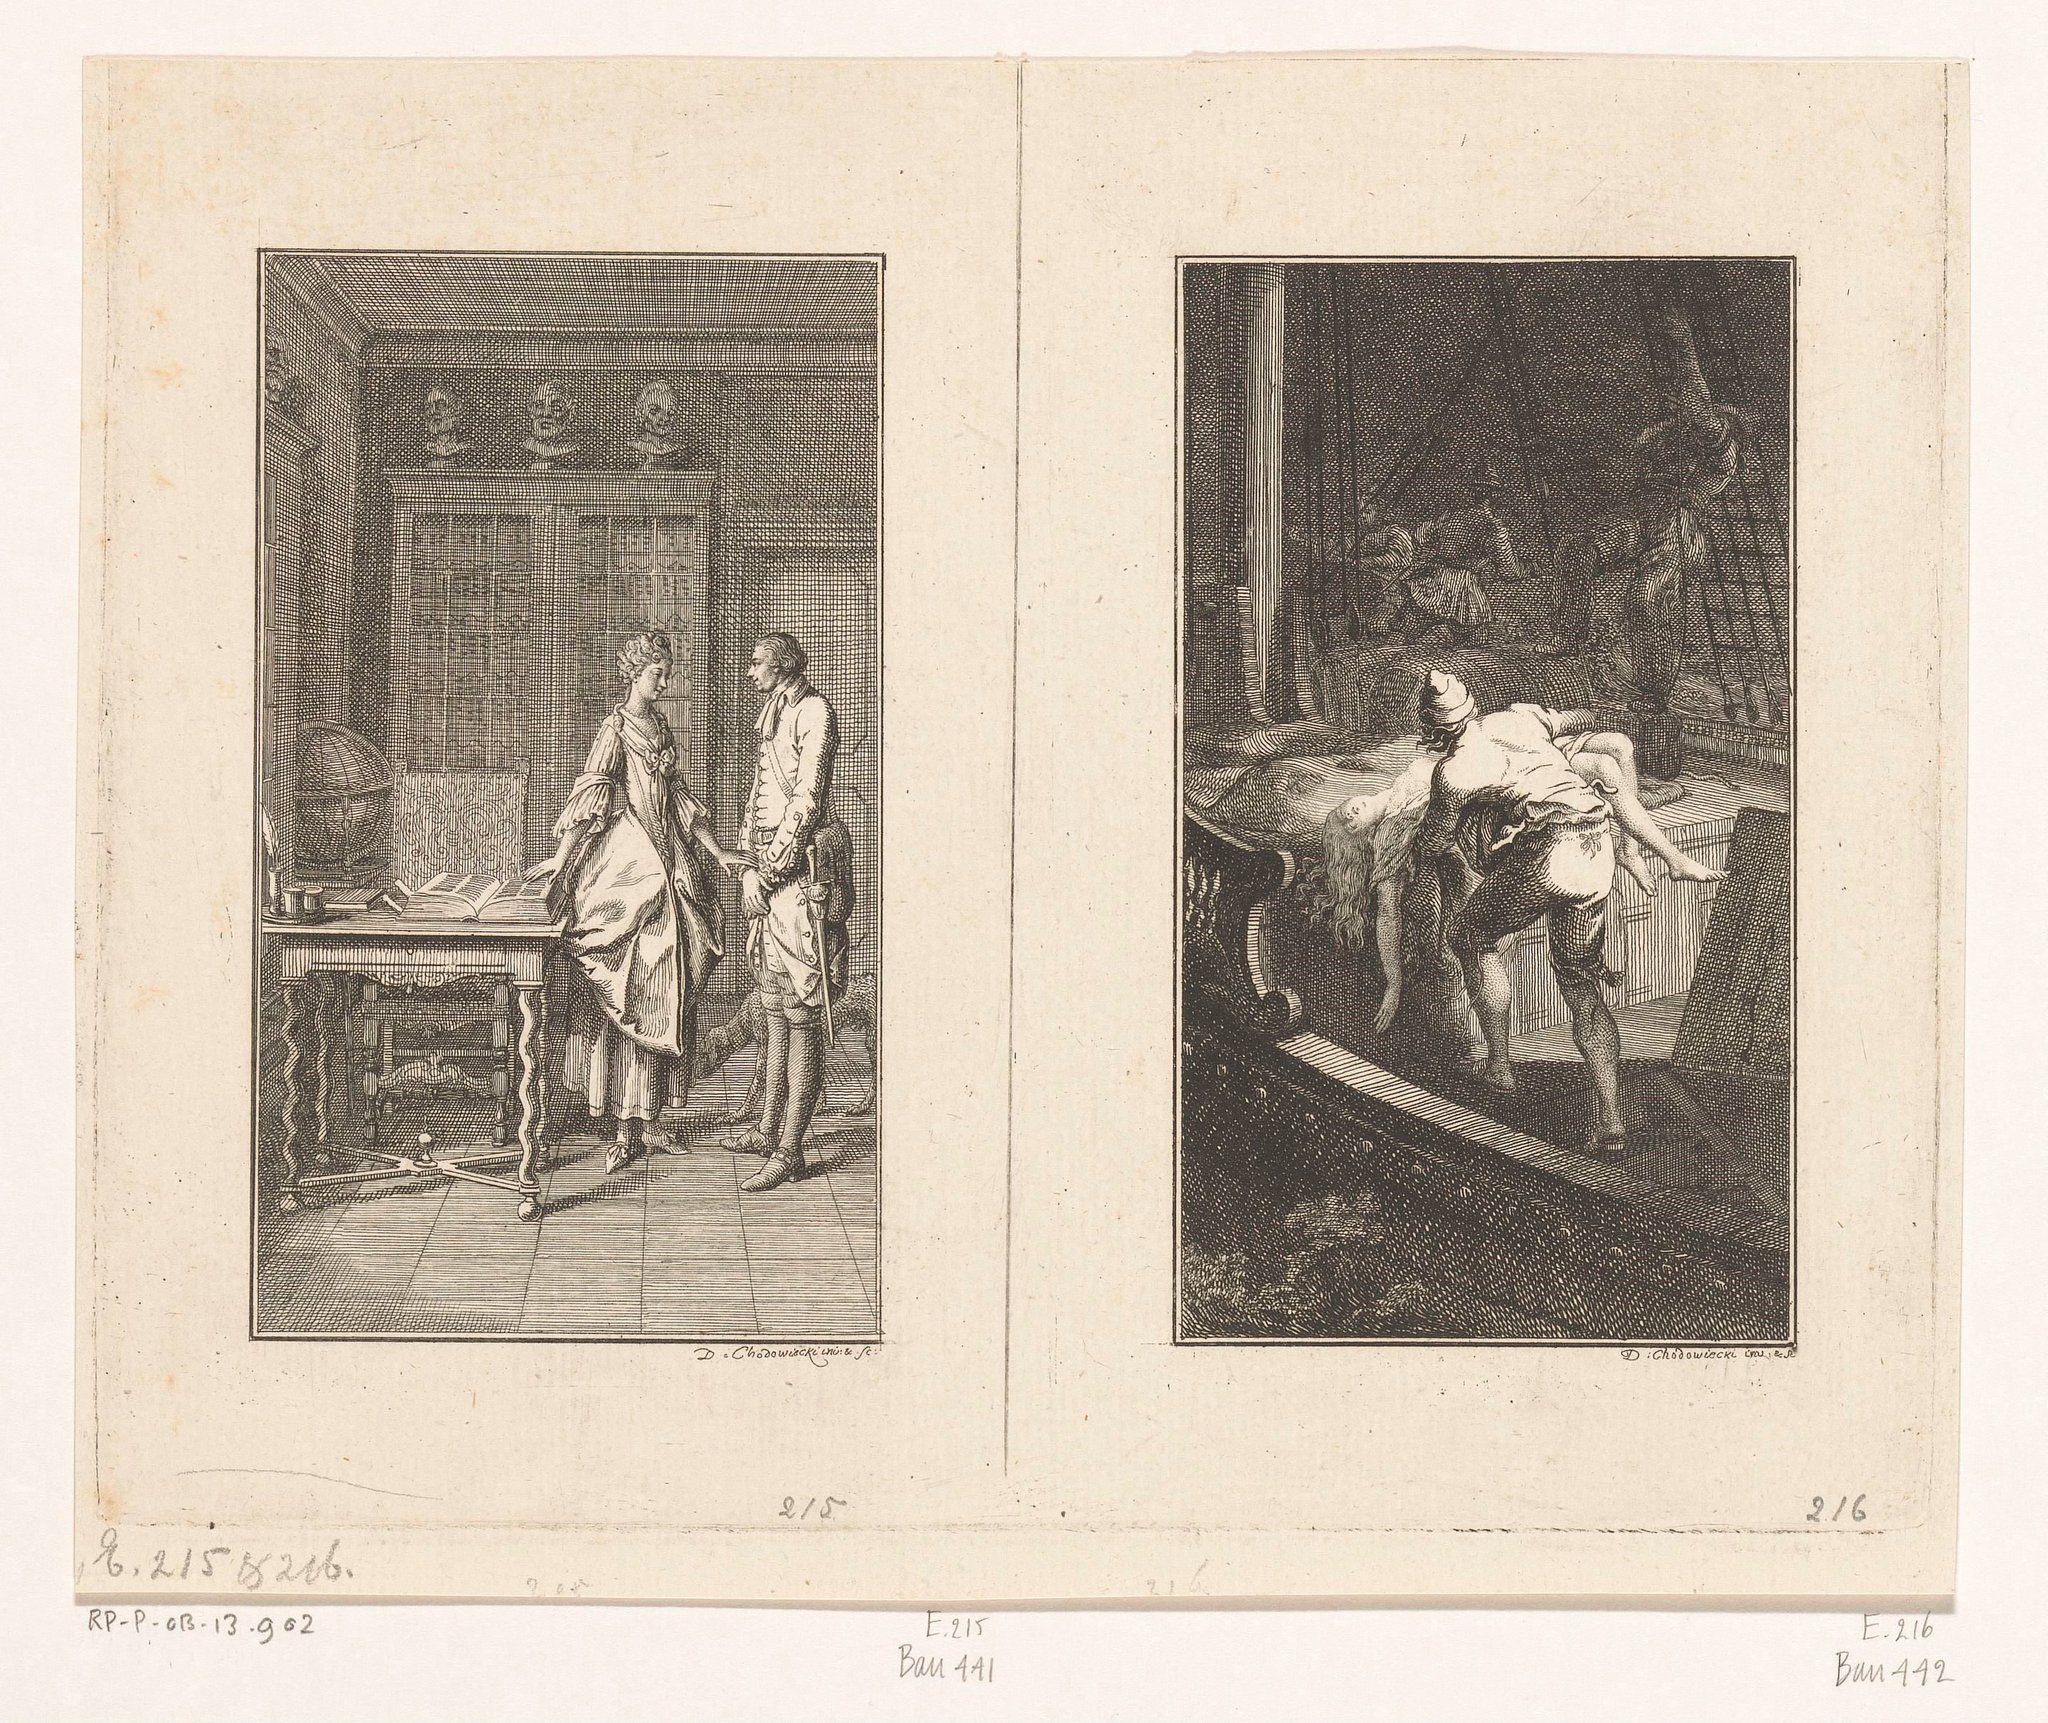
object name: print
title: Twee scènes uit Leben, Bemerkungen und Meinungen Johann Bunkels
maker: daniel nikolaus chodowiecki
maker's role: draughtsman, print maker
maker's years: 1726-1801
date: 1778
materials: paper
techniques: etching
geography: berlin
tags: literature, study; 'studiolo'; library, storm at sea, globe, saving a person from drowning, the bible as a book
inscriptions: collector's mark: Lugt 2228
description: Een latere staat van deze prenten is ook gebruikt in: Leben, Bemerkungen und Meinungen Johann Bunkels, nebst den Leben verscheidener merkwürdiger Frauenzimmer. 4 dln. Berlijn: Friedrich Nicolai, 1778. De Engelse uitgave verscheen tussen 1756-1766 onder de titel 'The life of John Buncle' en wordt meestal toegeschreven aan Thomas Armory. Chodowiecki etste in totaal 16 scènes voor dit werk.